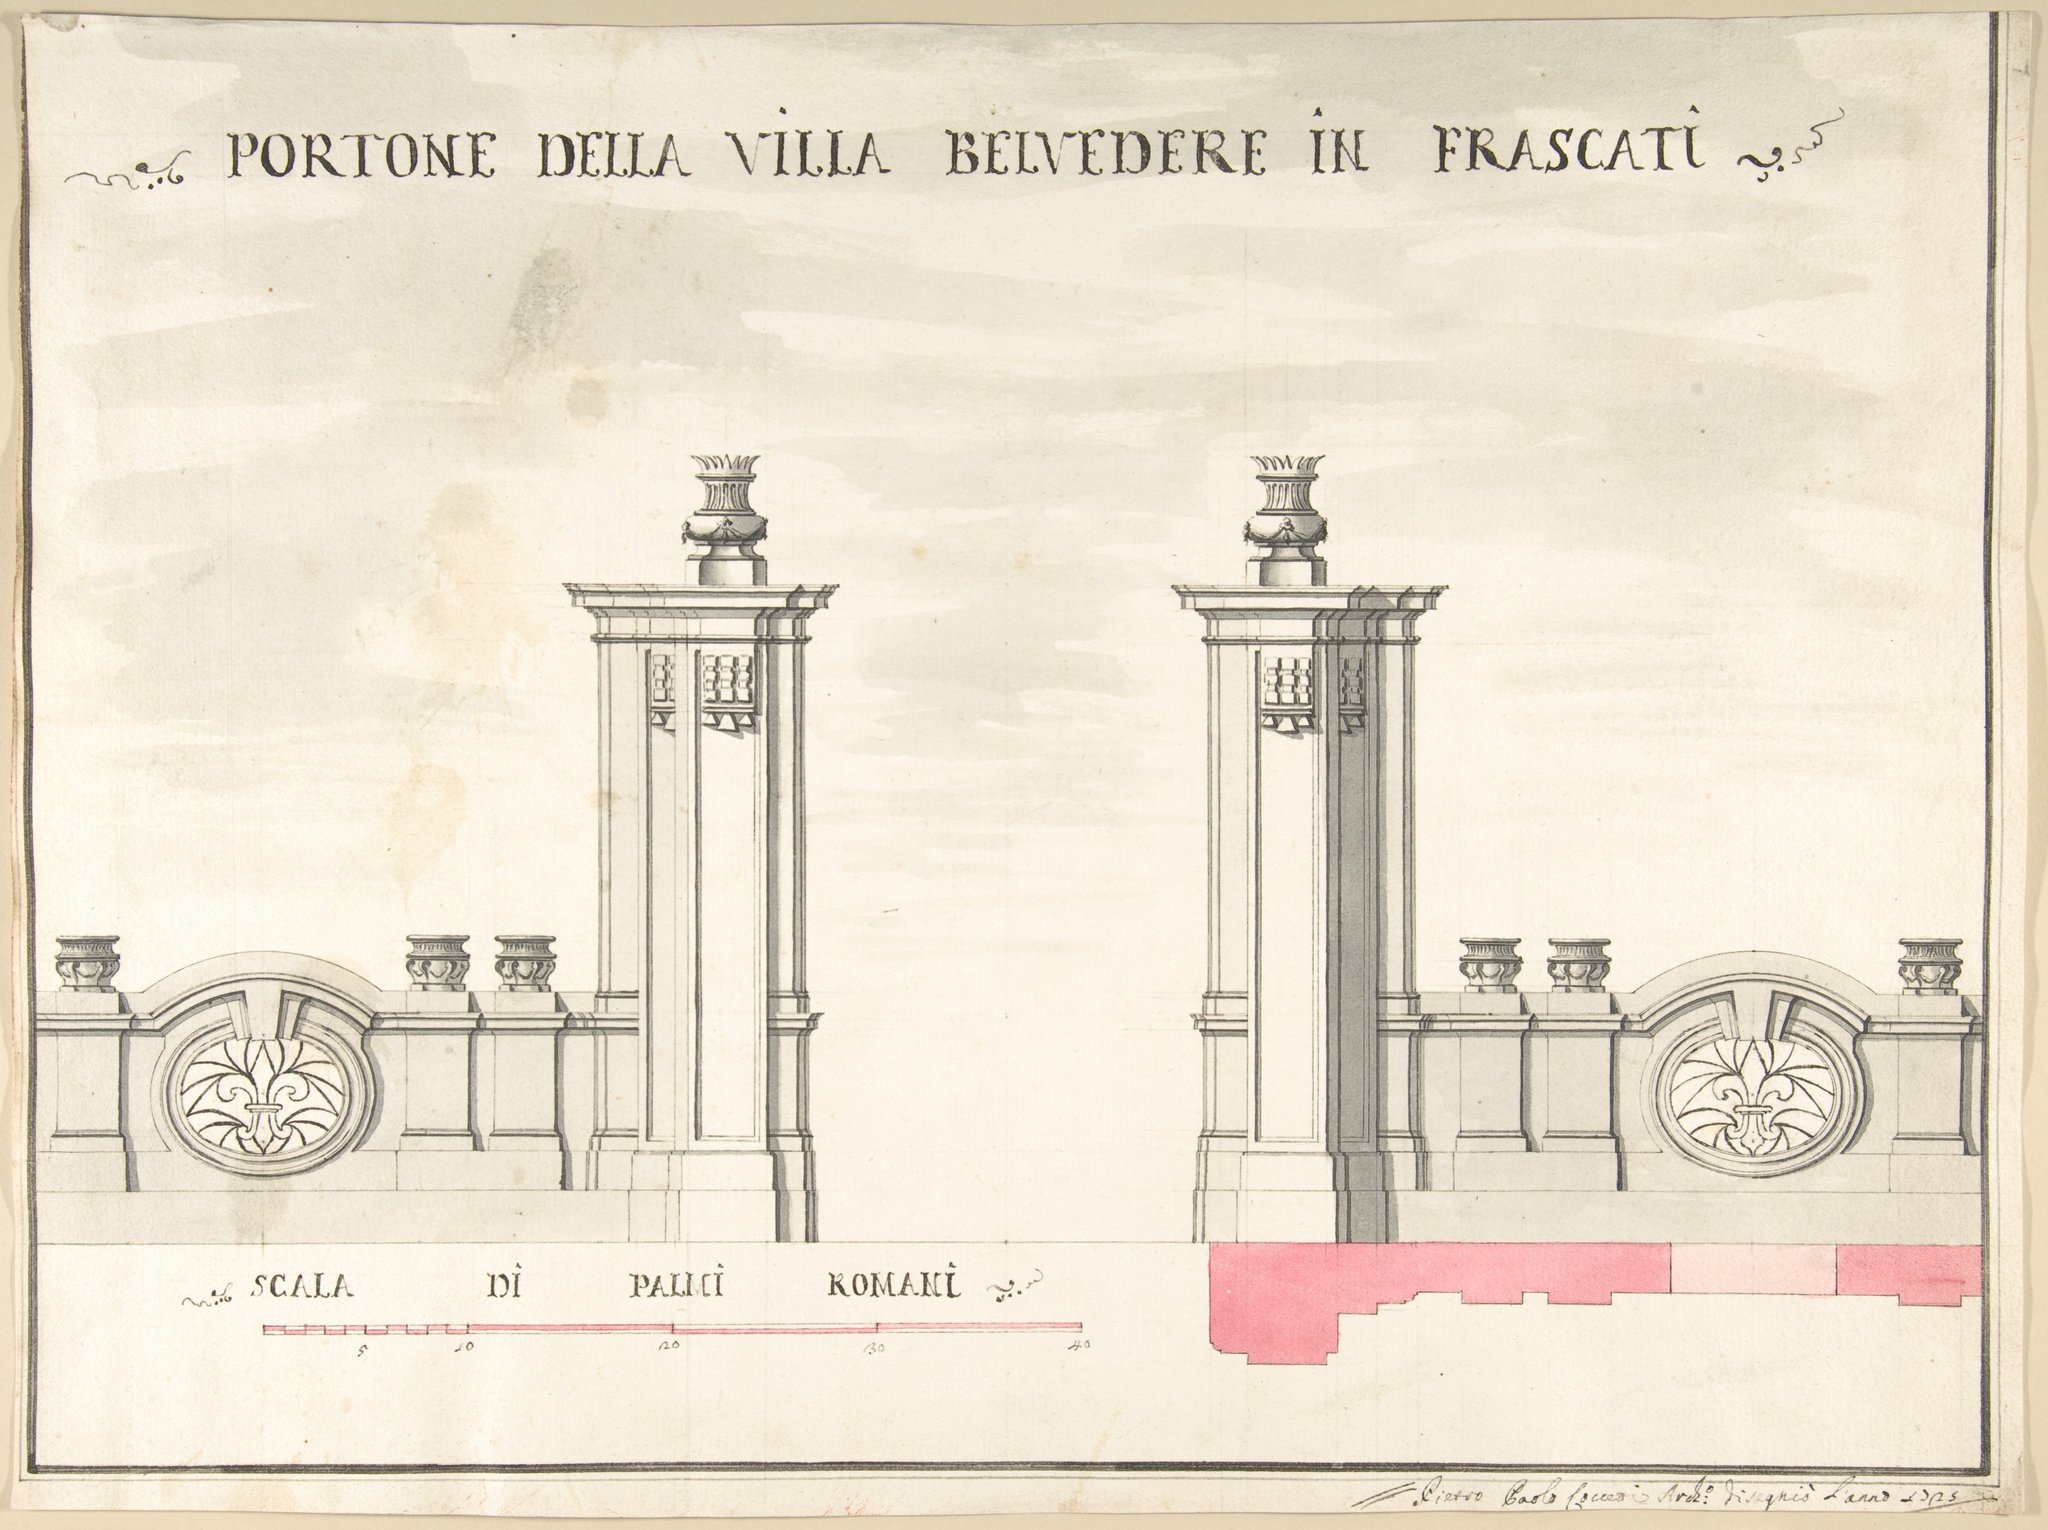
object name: drawing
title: Gate of Villa Belvedere in Frascati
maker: pietro paolo coccetti (cocchetti)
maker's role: artist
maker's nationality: italian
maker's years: 1710-1727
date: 1710-1727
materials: graphite, ink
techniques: brush, pen, wash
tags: architecture,gates